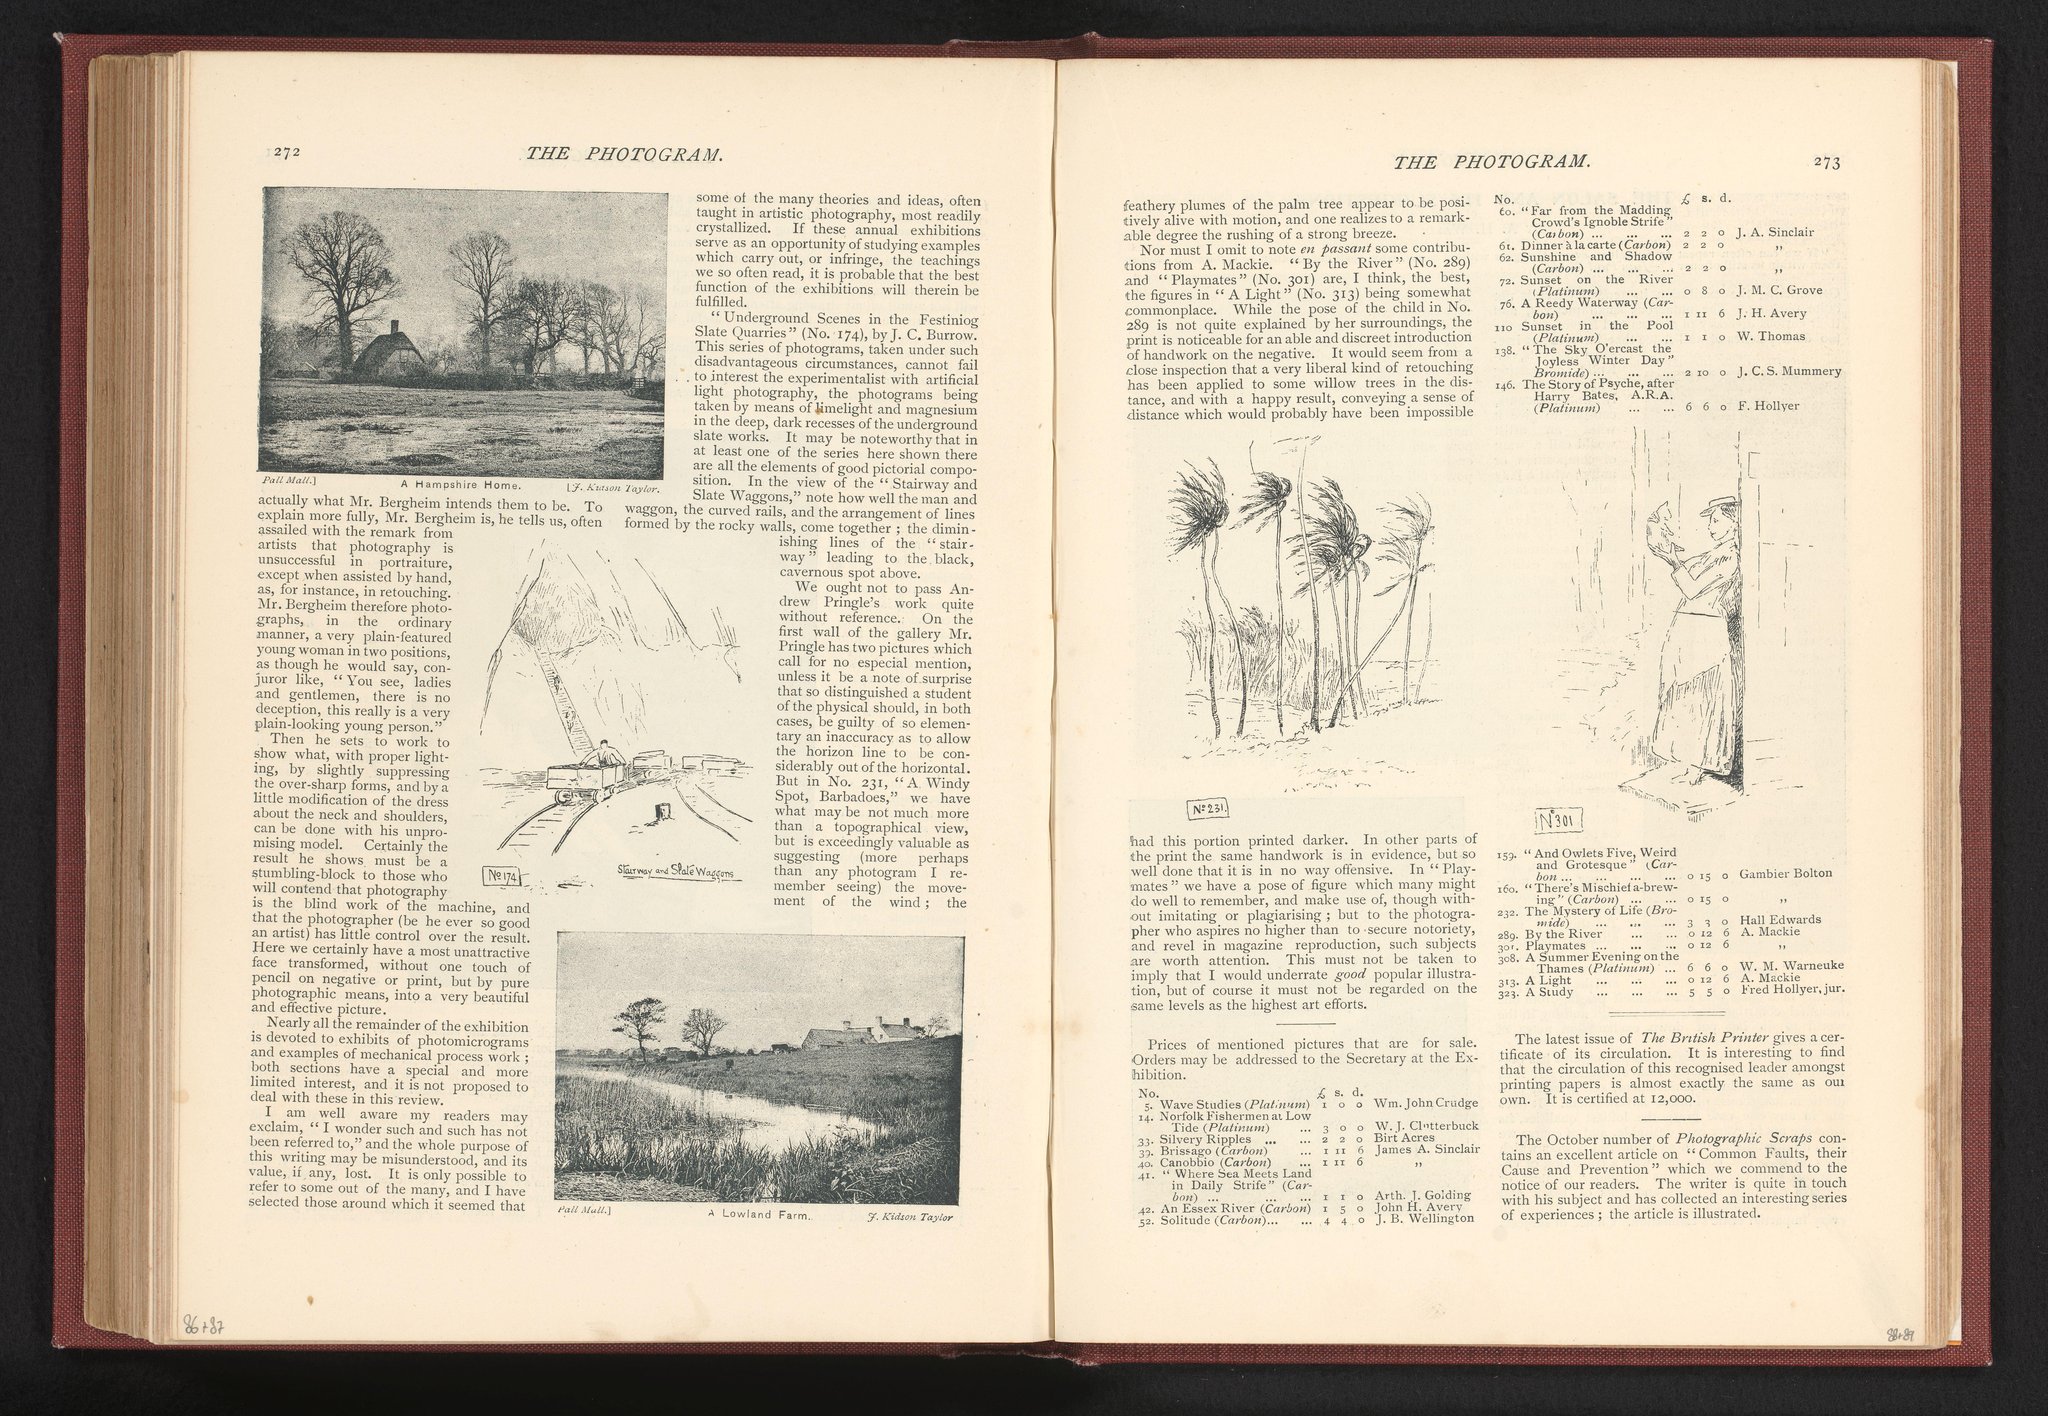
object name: page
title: Landschap met huis in Hampshire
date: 1889-1894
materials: paper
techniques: autotype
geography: hampshire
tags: landscapes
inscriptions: inscription: ‘Pall Mall’